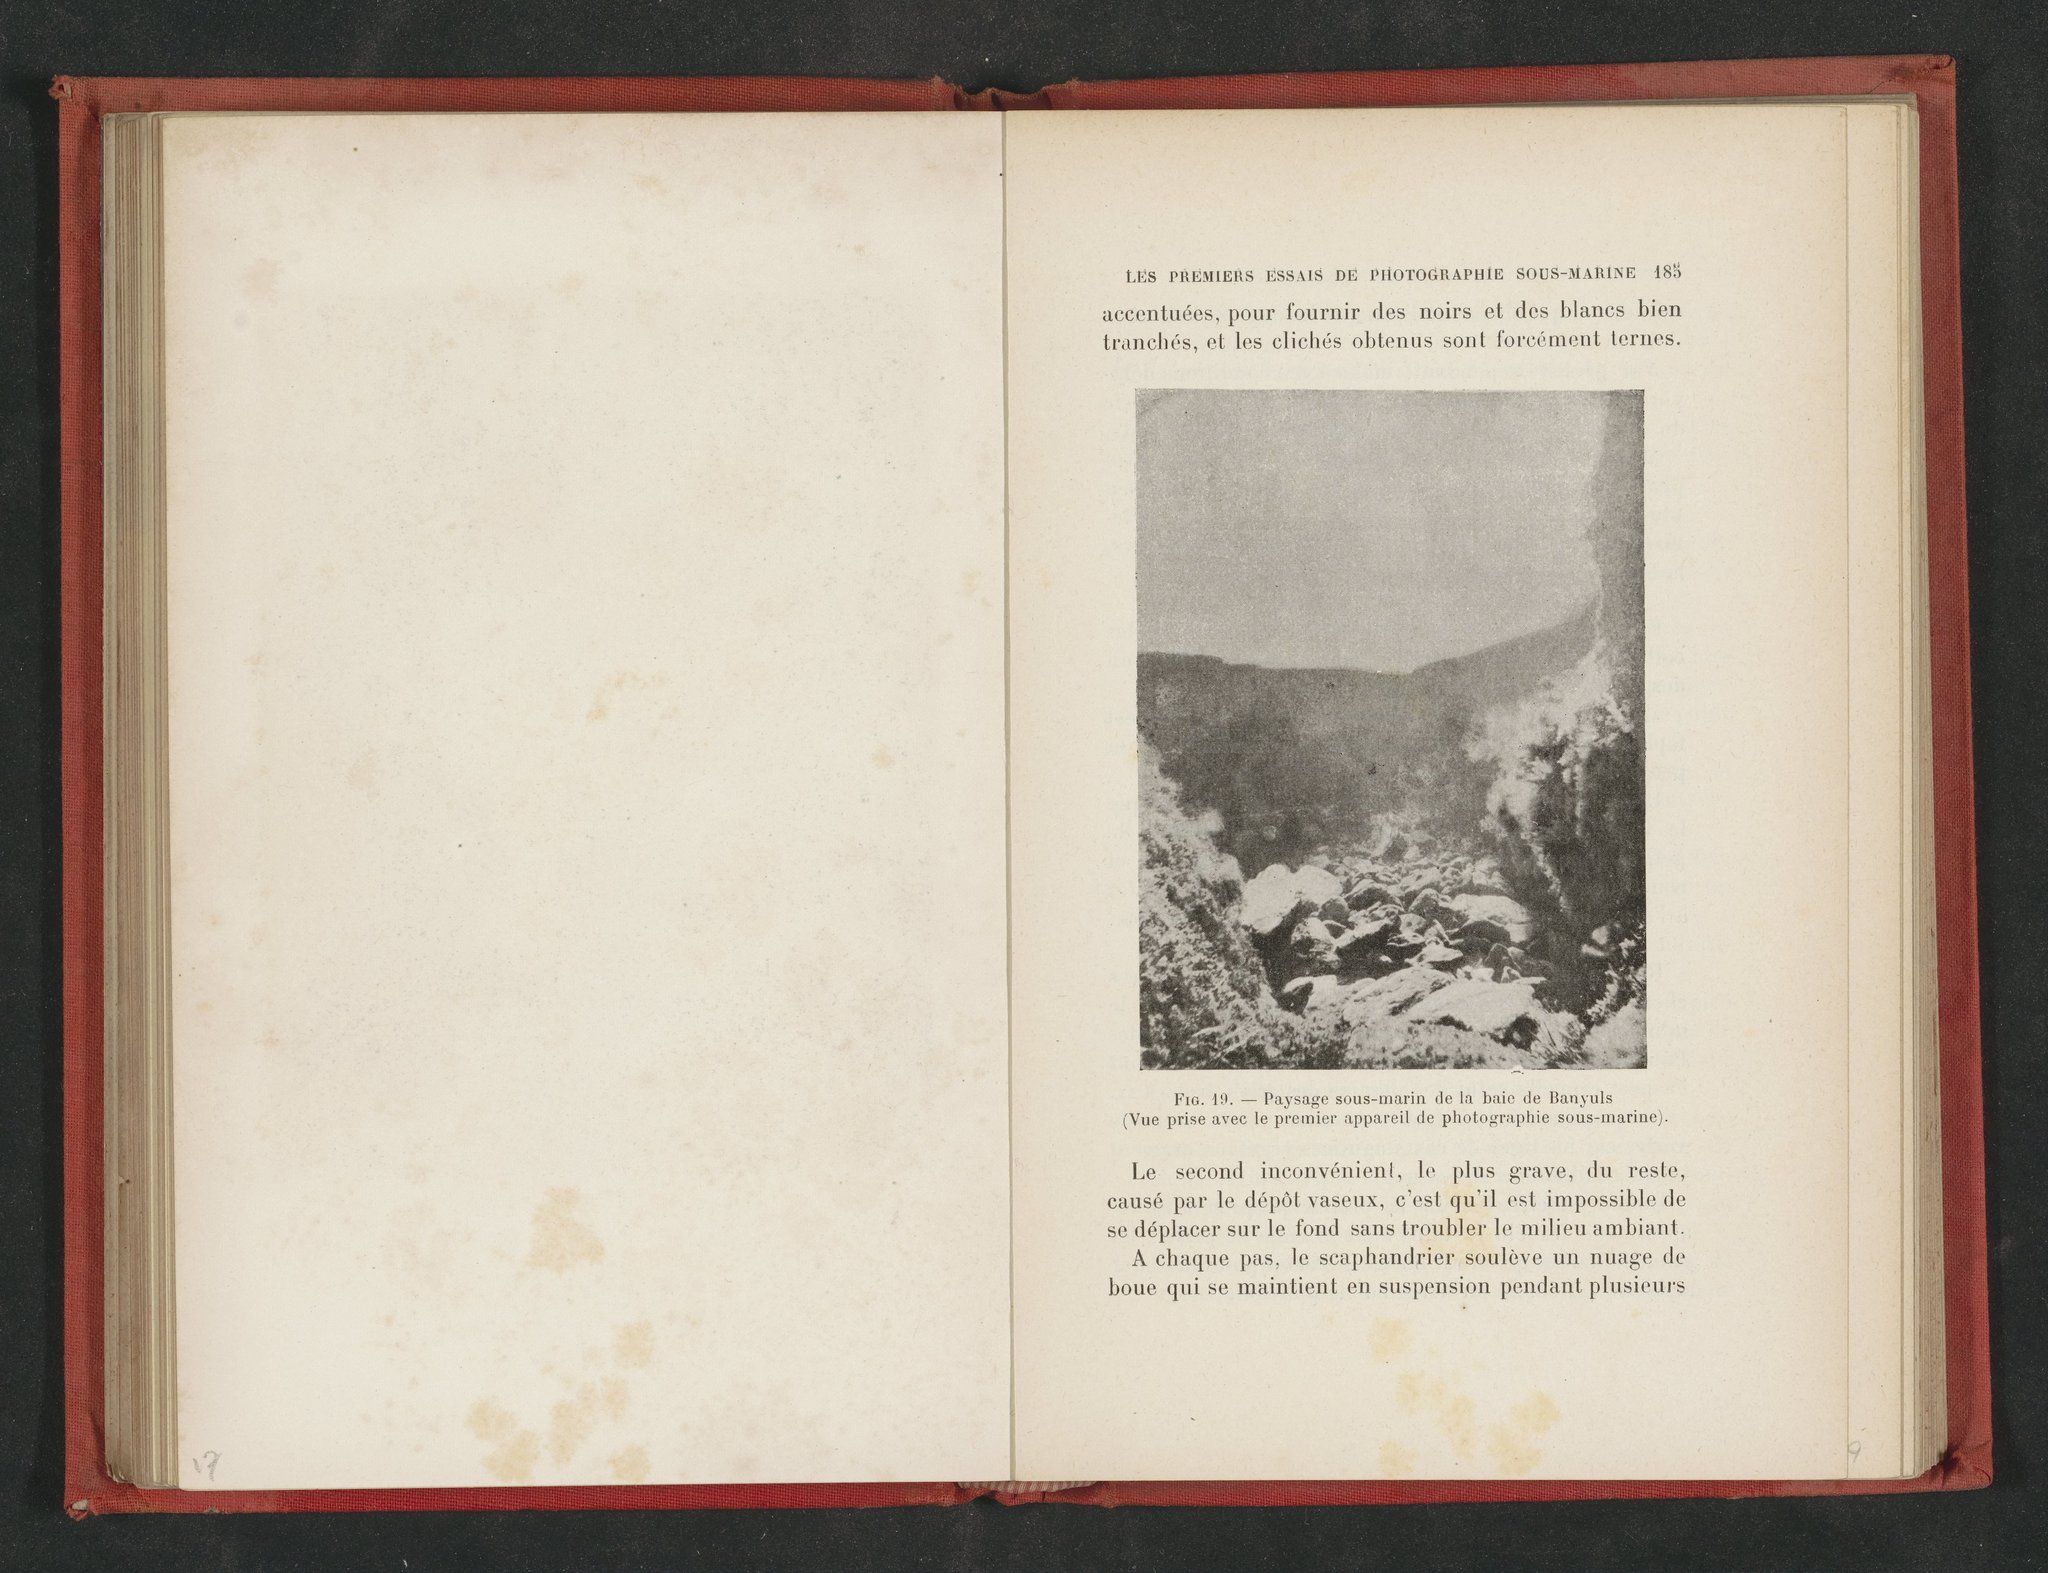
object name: photomechanical print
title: Onderwaterlandschap in de baai van Banyuls-sur-Mer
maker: Anonymous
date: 1890-1900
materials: paper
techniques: autotype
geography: france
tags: landscapes with waters, waterscapes, seascapes (in the temperate zone)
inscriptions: number: ‘Fig. 19.’